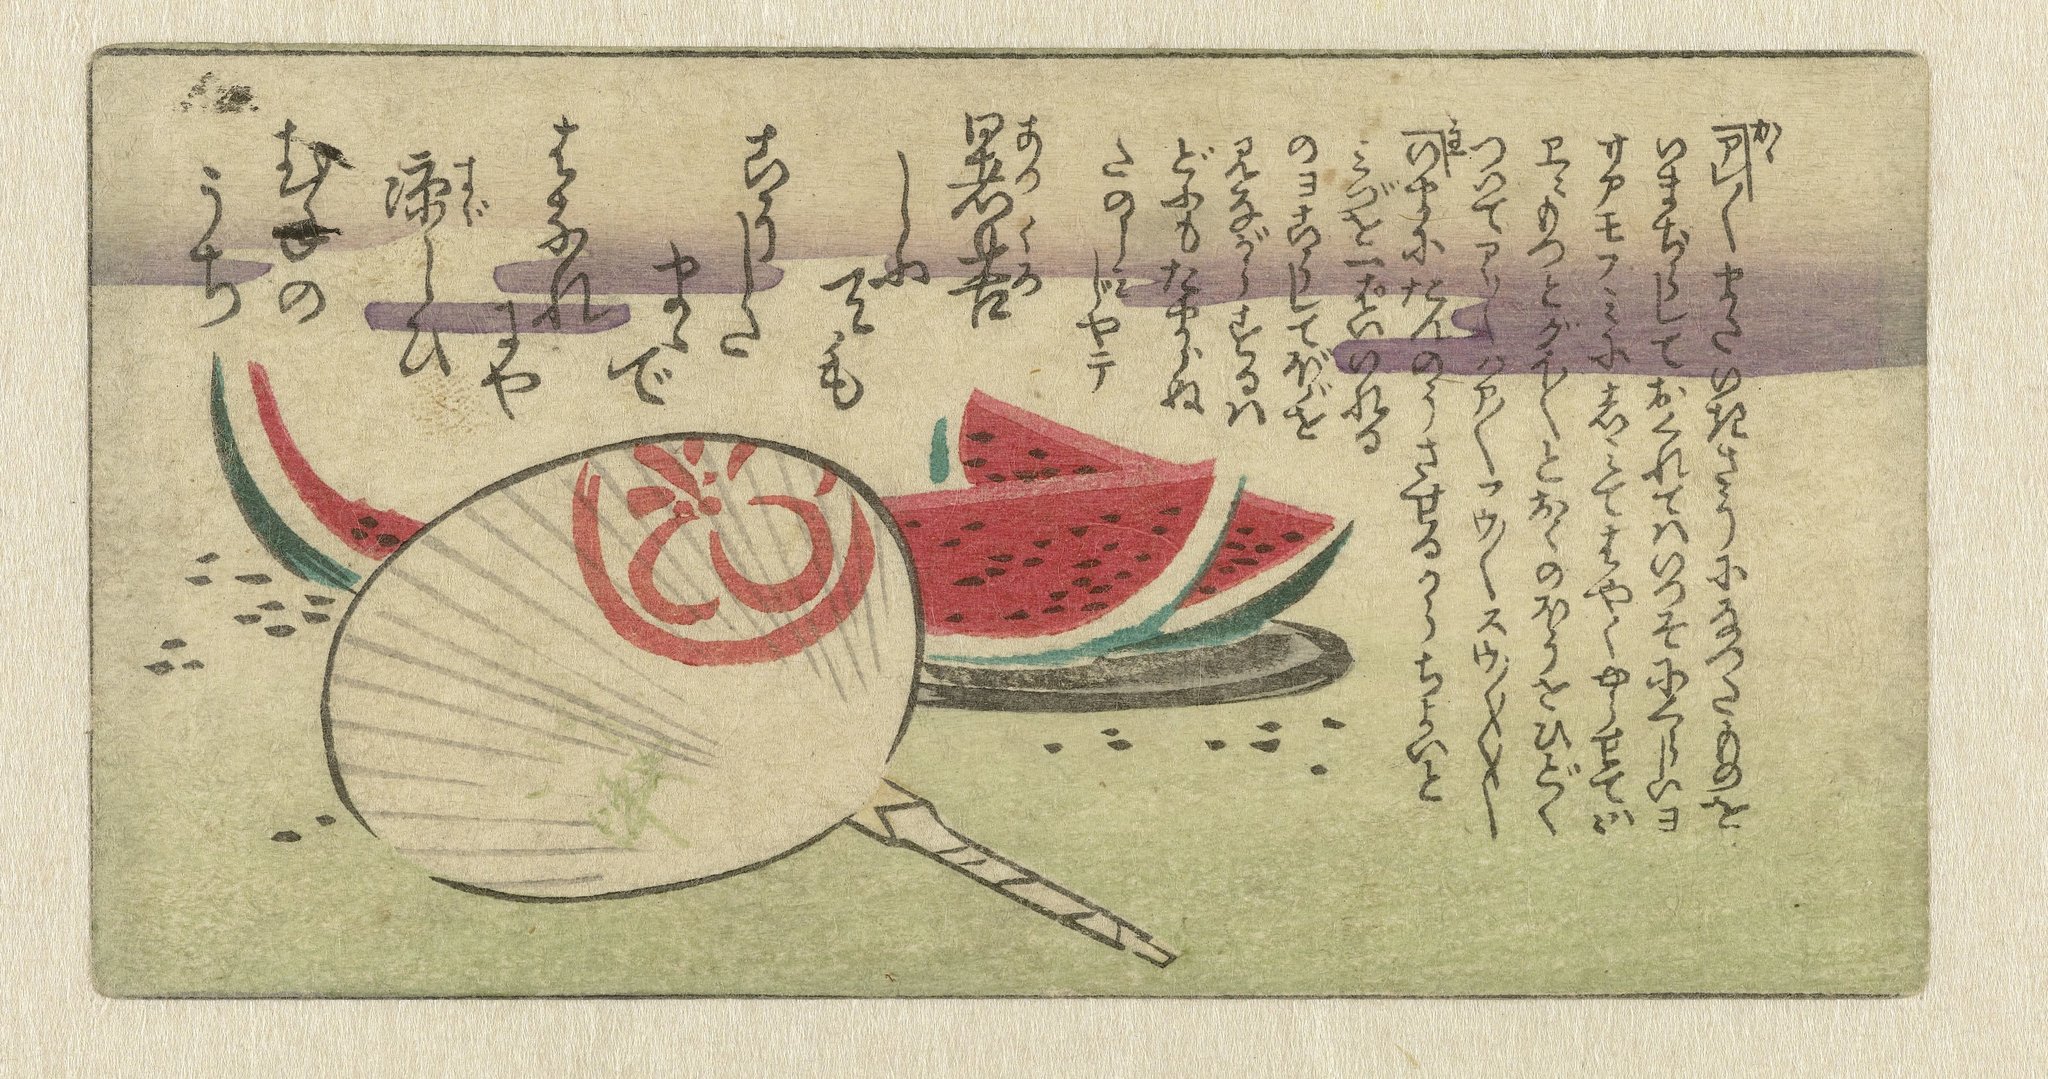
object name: print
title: Waaier en schijven meloen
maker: Anonymous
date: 1850-1860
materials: paper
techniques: woodcut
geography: japan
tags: fruits: melon, fan, oriental ideographic script (chinese, korean, japanese)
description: Een waaier en drie schijven watermeloen, met een begleidende tekst bij de 'gelooide waaier'.